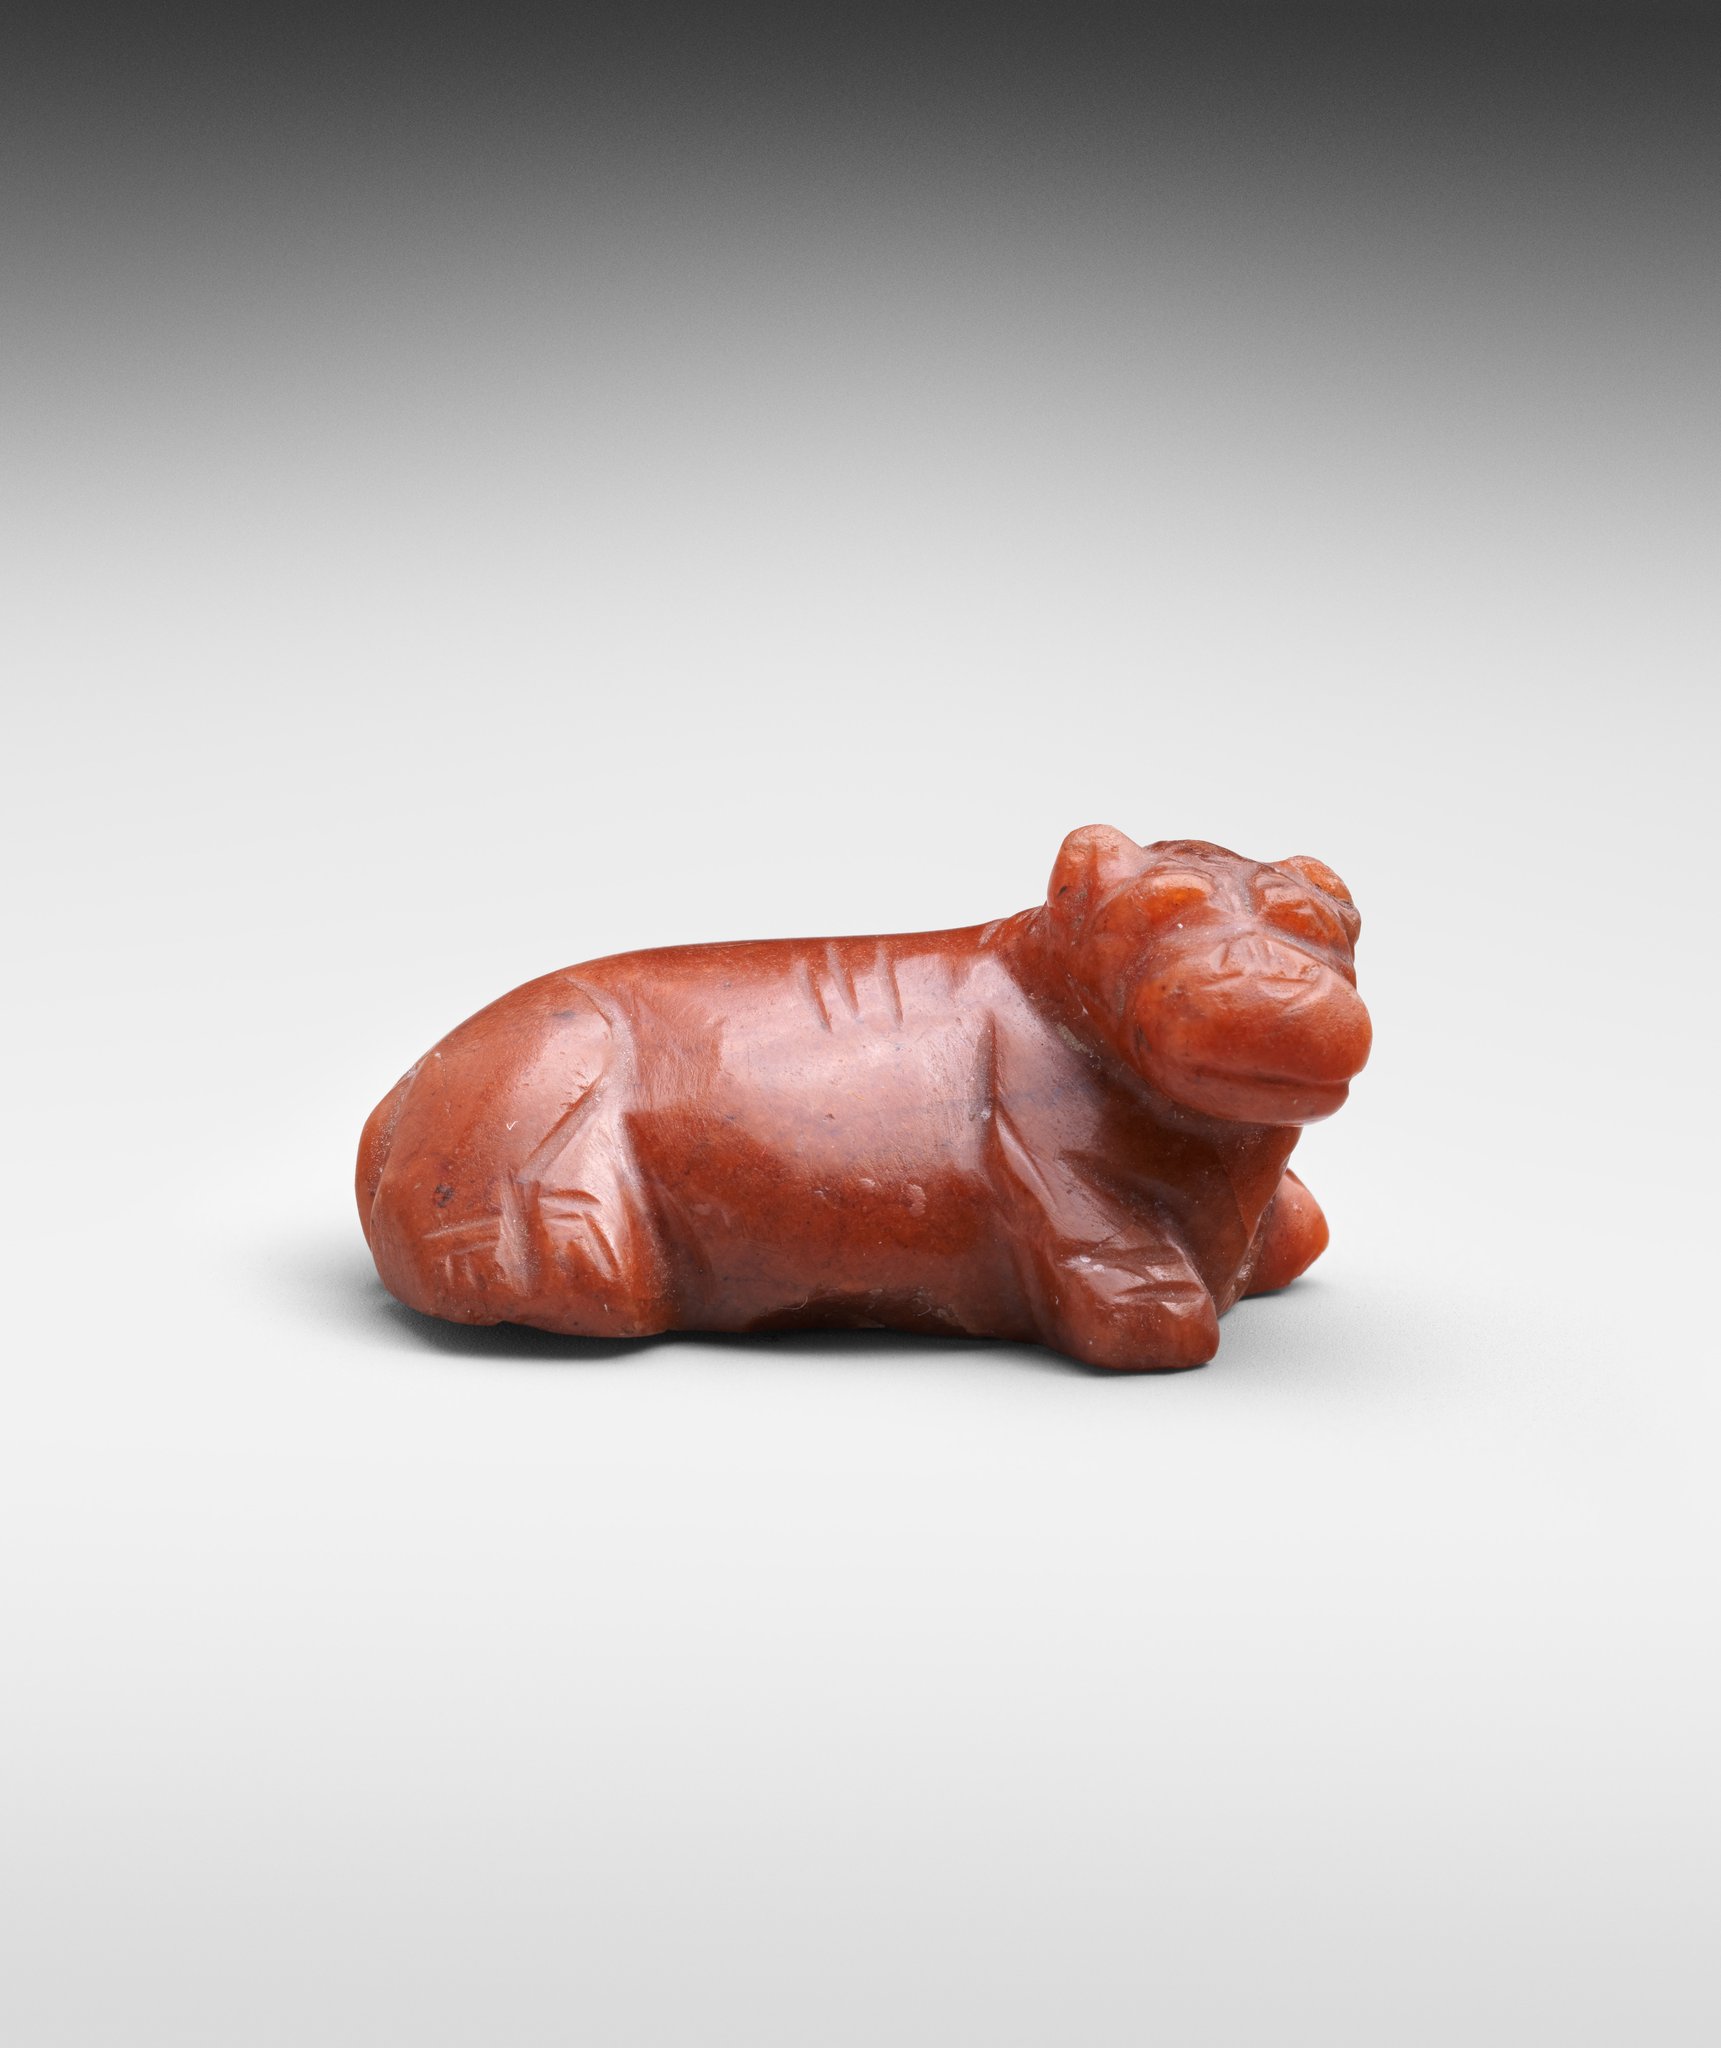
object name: figurine, hippopotamus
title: Hippopotamus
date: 1550-1070 BCE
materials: jasper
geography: egypt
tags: hippos